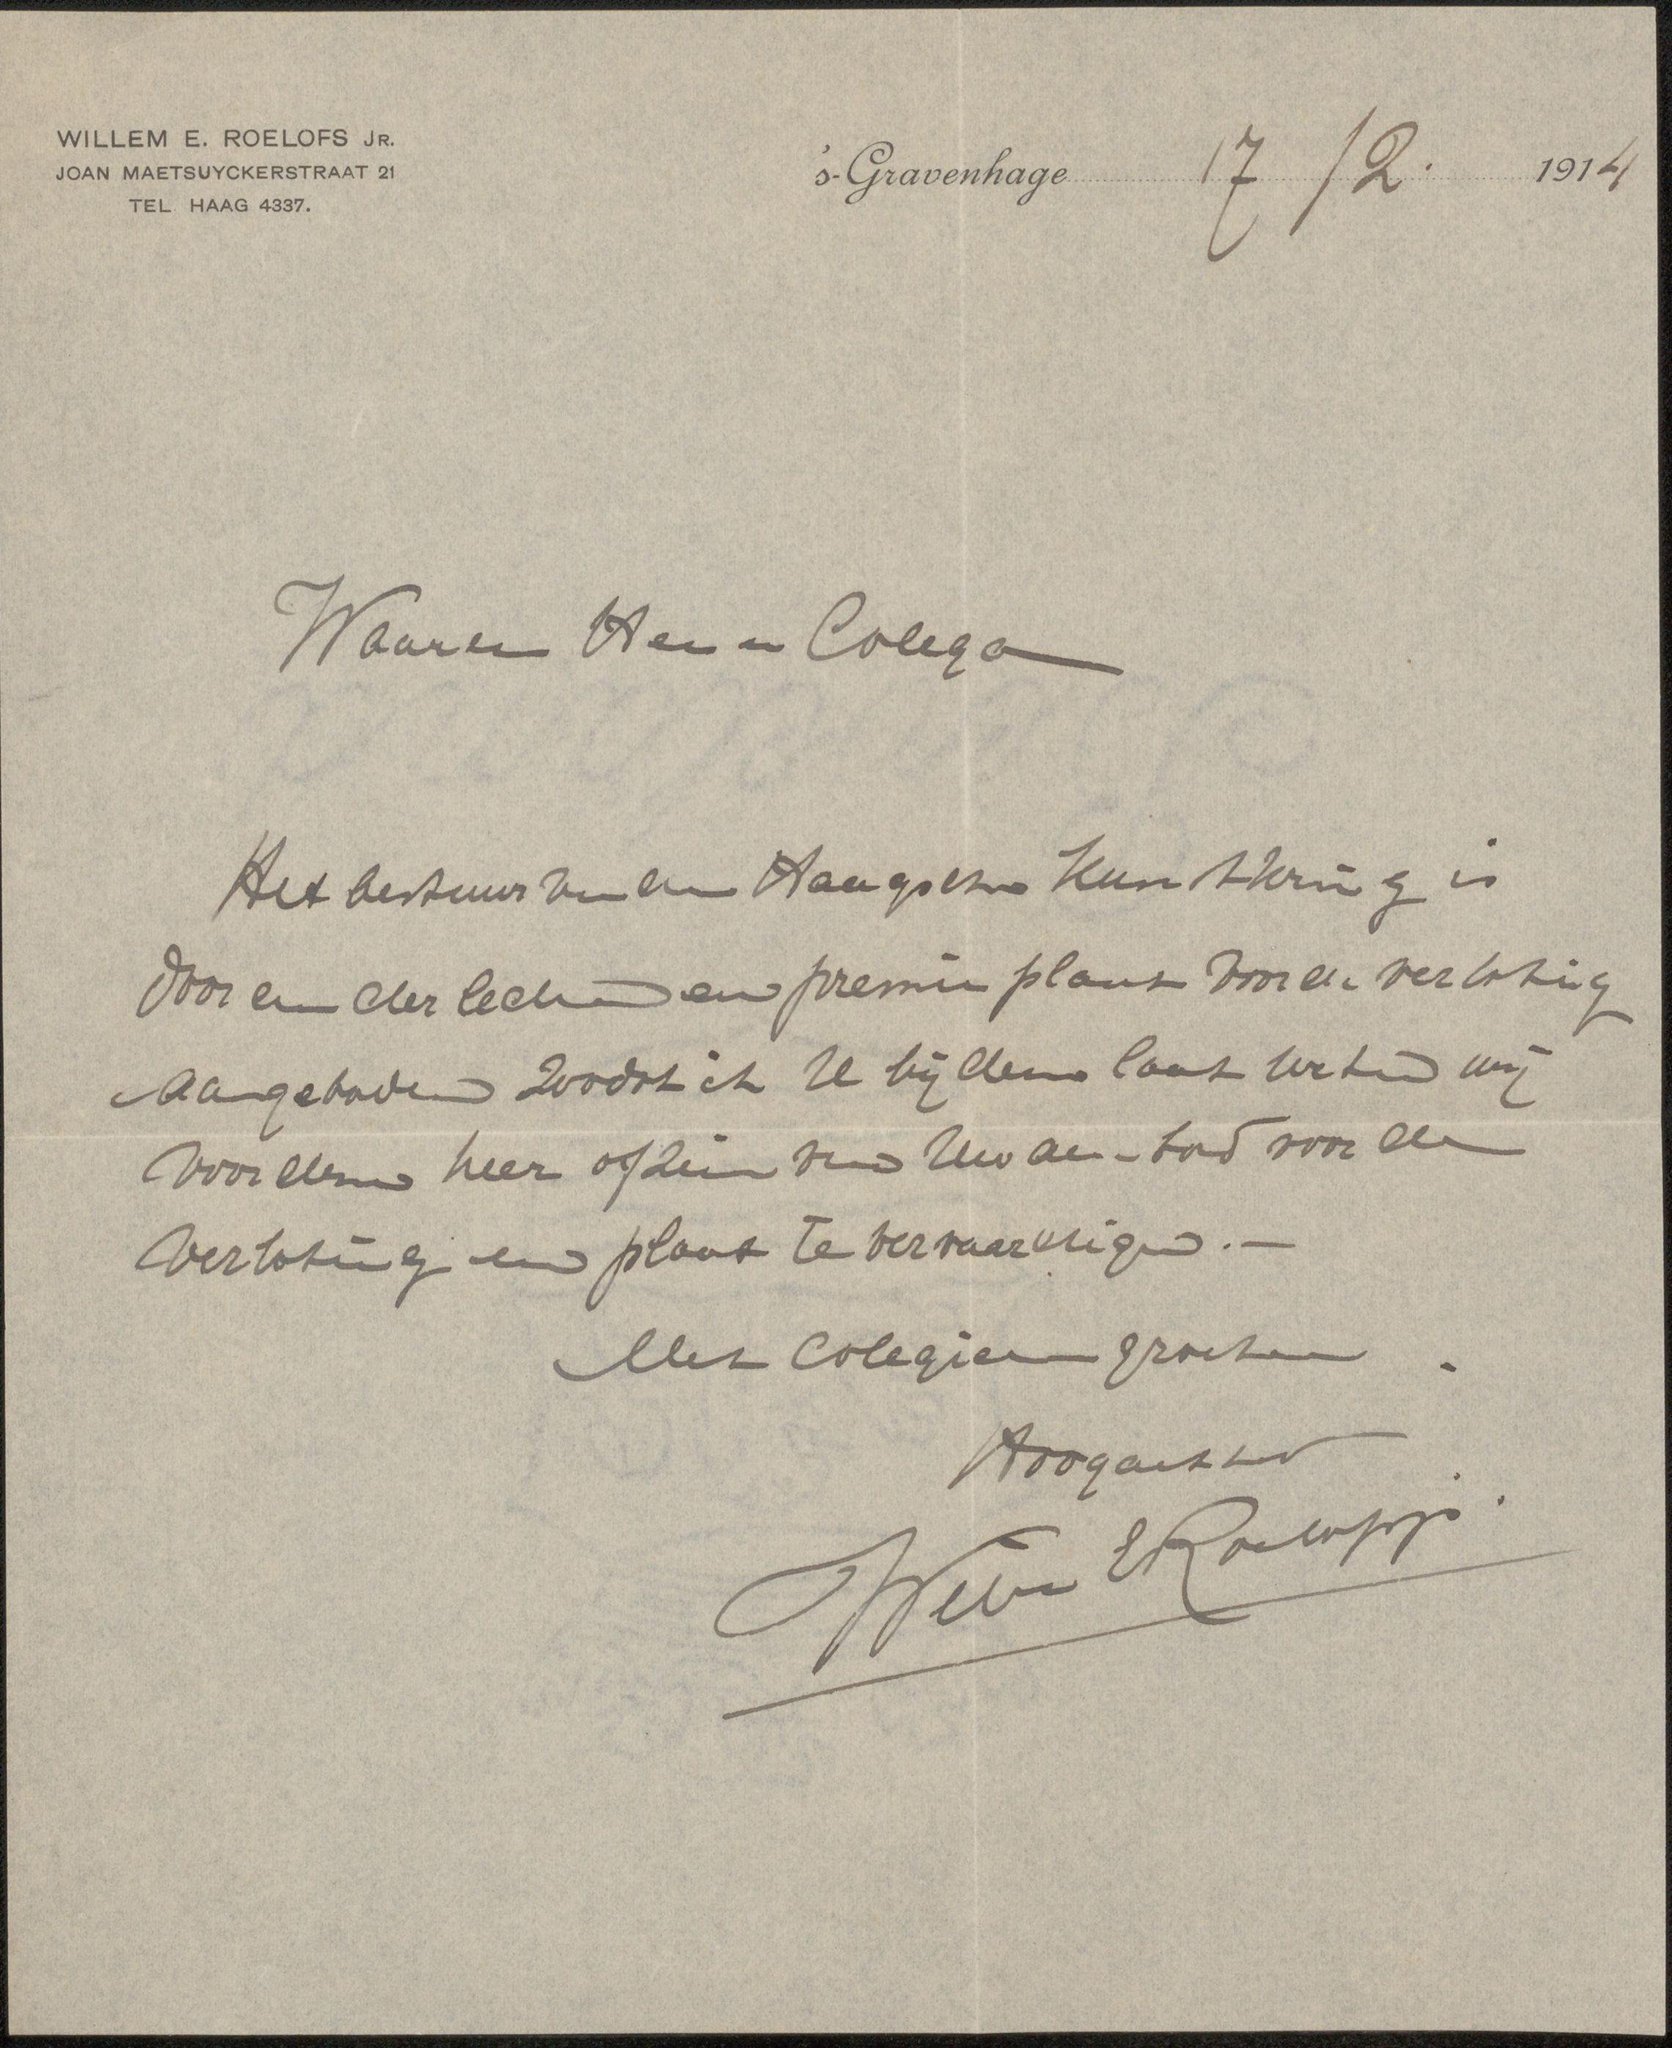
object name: letter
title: Brief aan Philip Zilcken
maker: willem roelofs (ii)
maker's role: draughtsman, painter, print maker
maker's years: 1874-1940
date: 1914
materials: ink, paper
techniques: pen, printing, writing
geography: the hague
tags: the hague, painter, philip zilcken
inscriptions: collector's mark: ‘RPK’